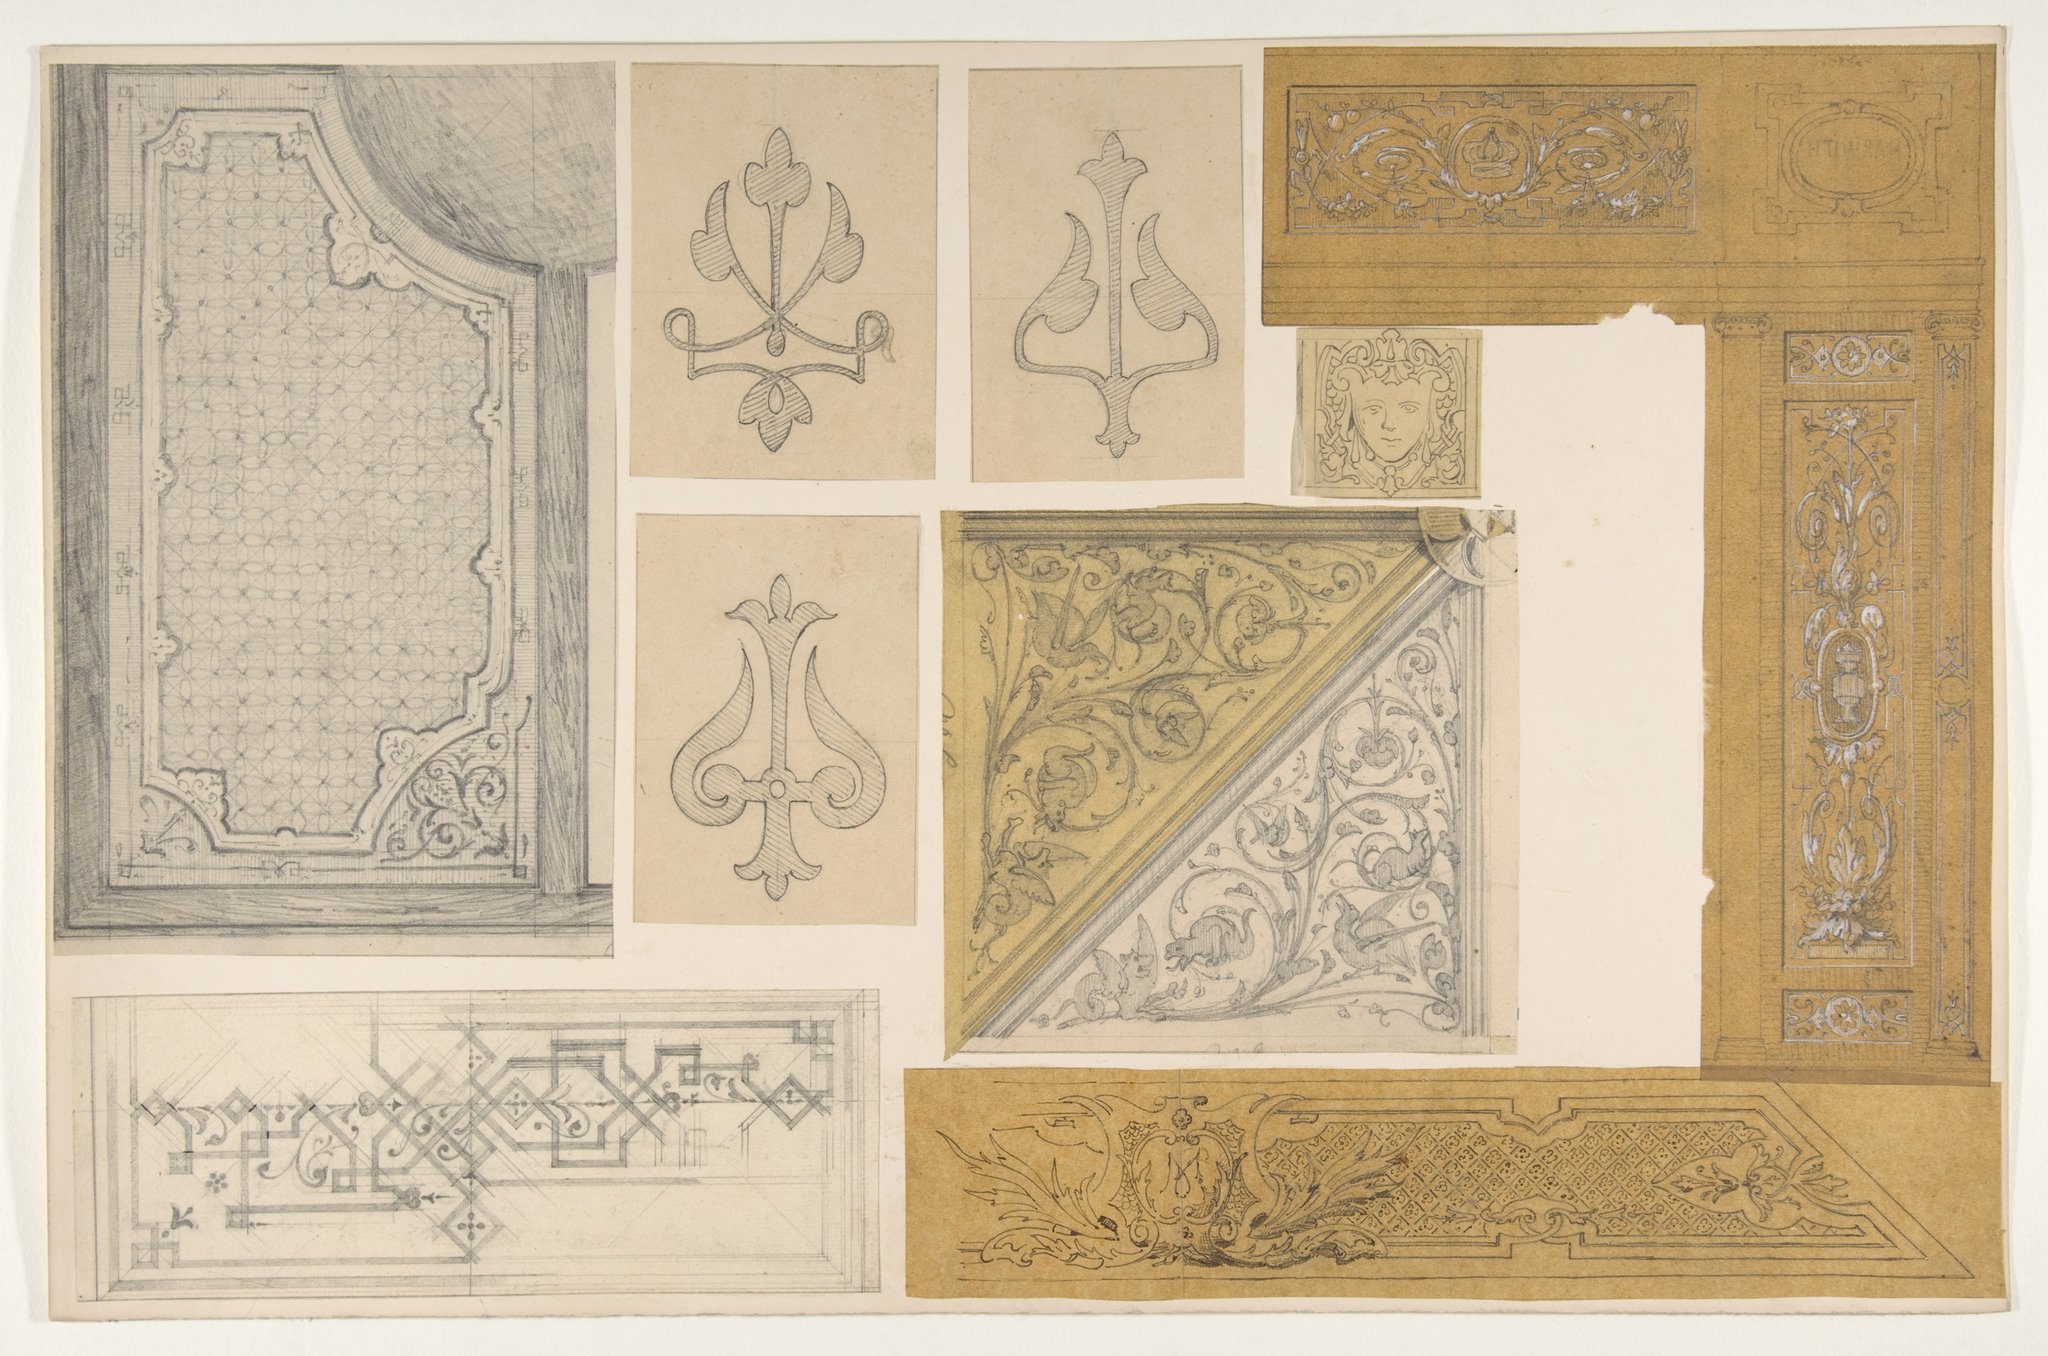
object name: drawing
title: Ten designs for the painted decoration of an interior; one possibly for "Harwith"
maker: jules-edmond-charles lachaise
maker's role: artist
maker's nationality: french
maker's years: 1897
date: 1851-1900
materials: graphite, ink, paper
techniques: pen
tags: ornament